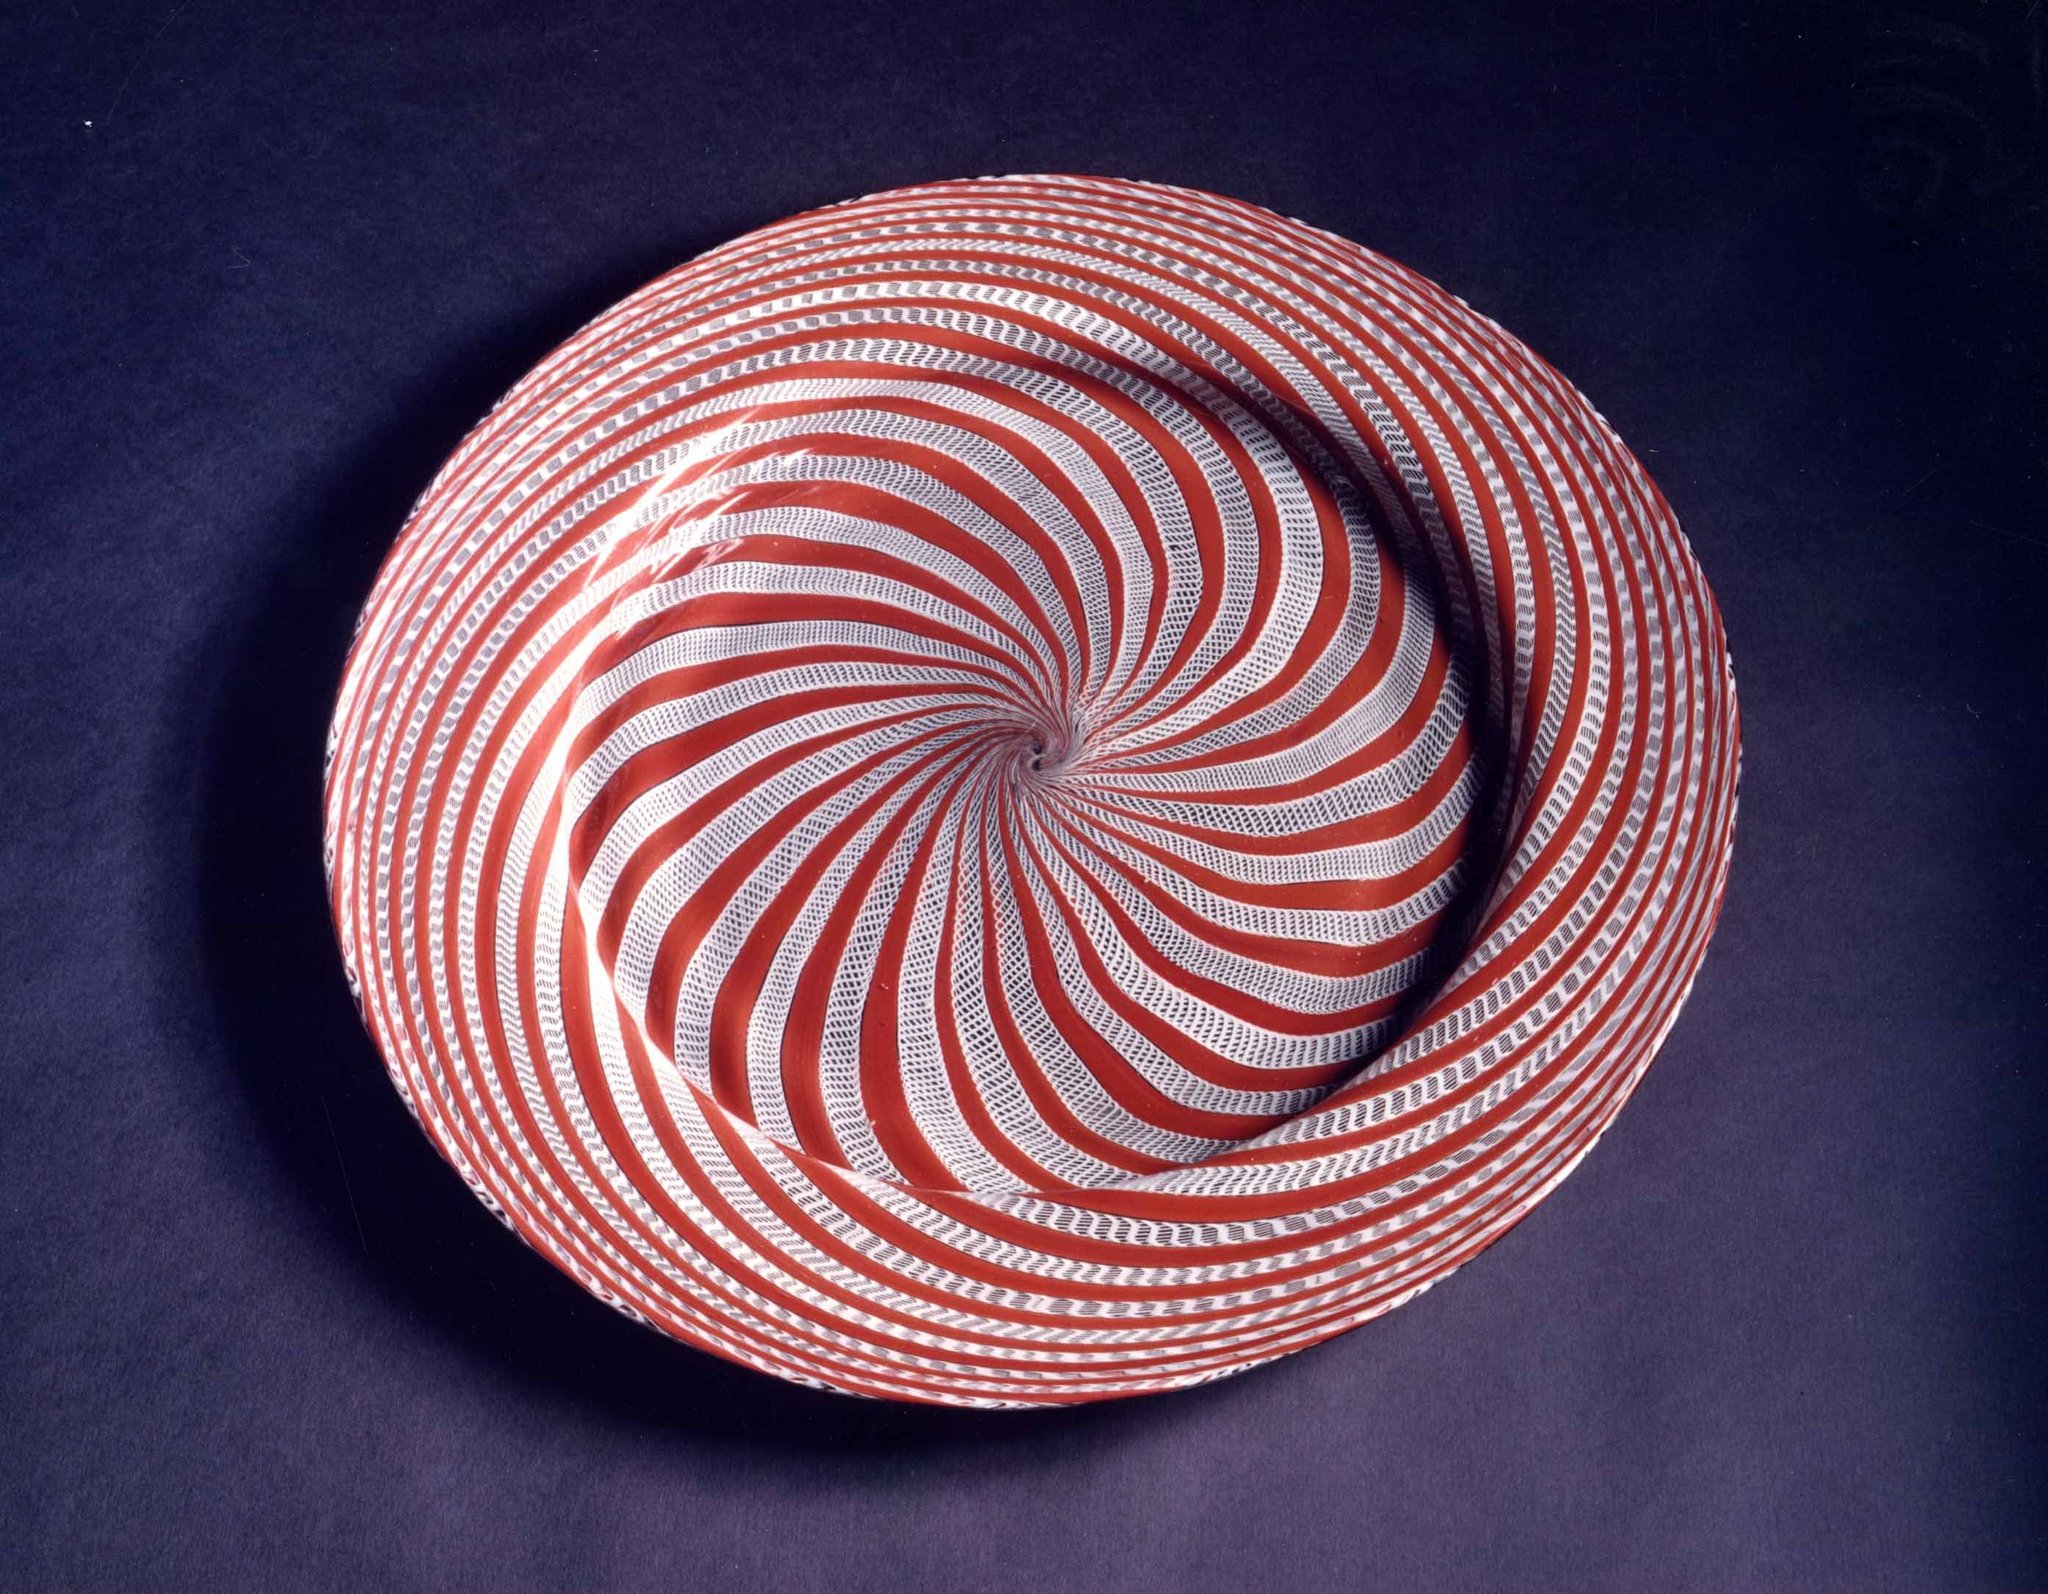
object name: plate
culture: italian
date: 1667-1700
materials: glass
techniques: glassblowing